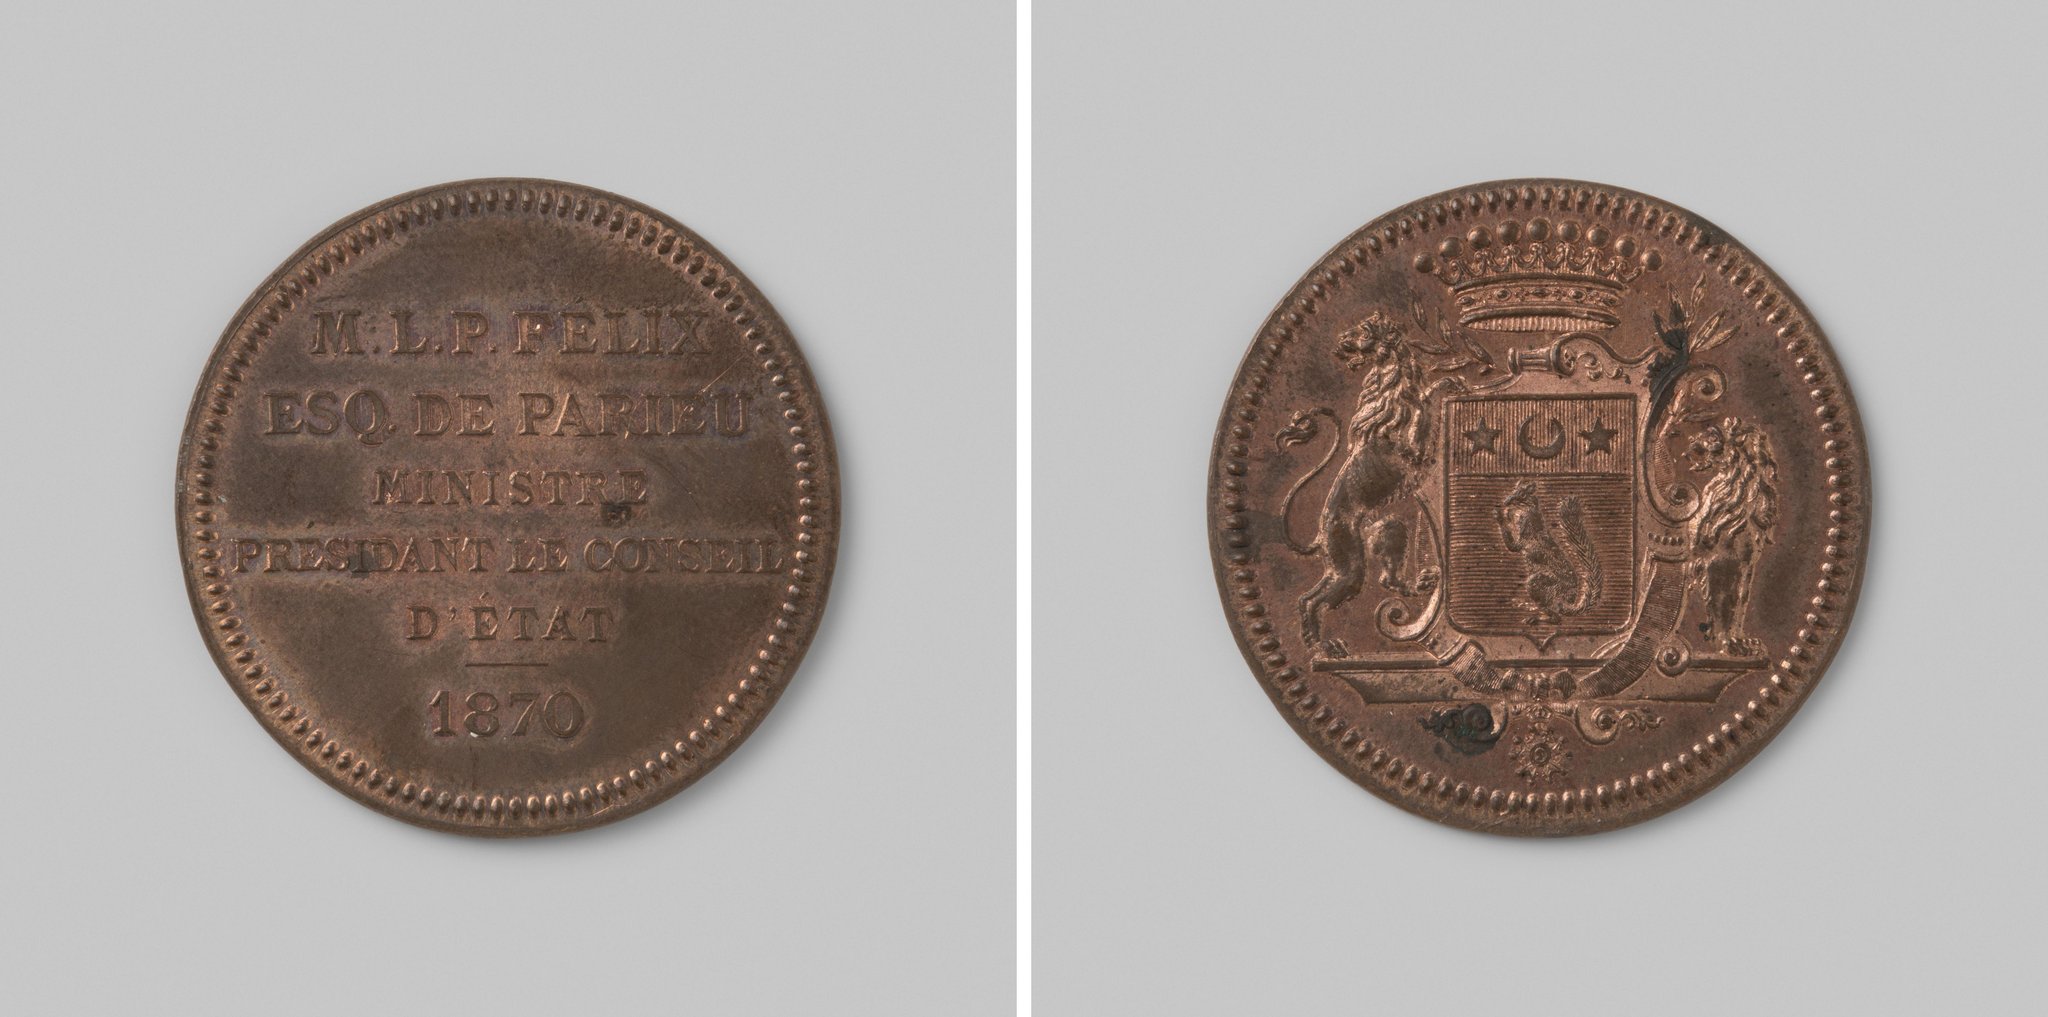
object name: jeton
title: Marie Louis Pierre Felix Esquiron de Parieu, minister en voorzitter van de Staatsraad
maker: Anonymous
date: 1870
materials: copper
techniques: striking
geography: france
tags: marie louis pierre felix esquiron de parieu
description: Koperen penning. Voorzijde: opschrift. Keerzijde: gekroond wapenschild, geflankeerd door een staande en een zittende leeuw, omhangen met orde